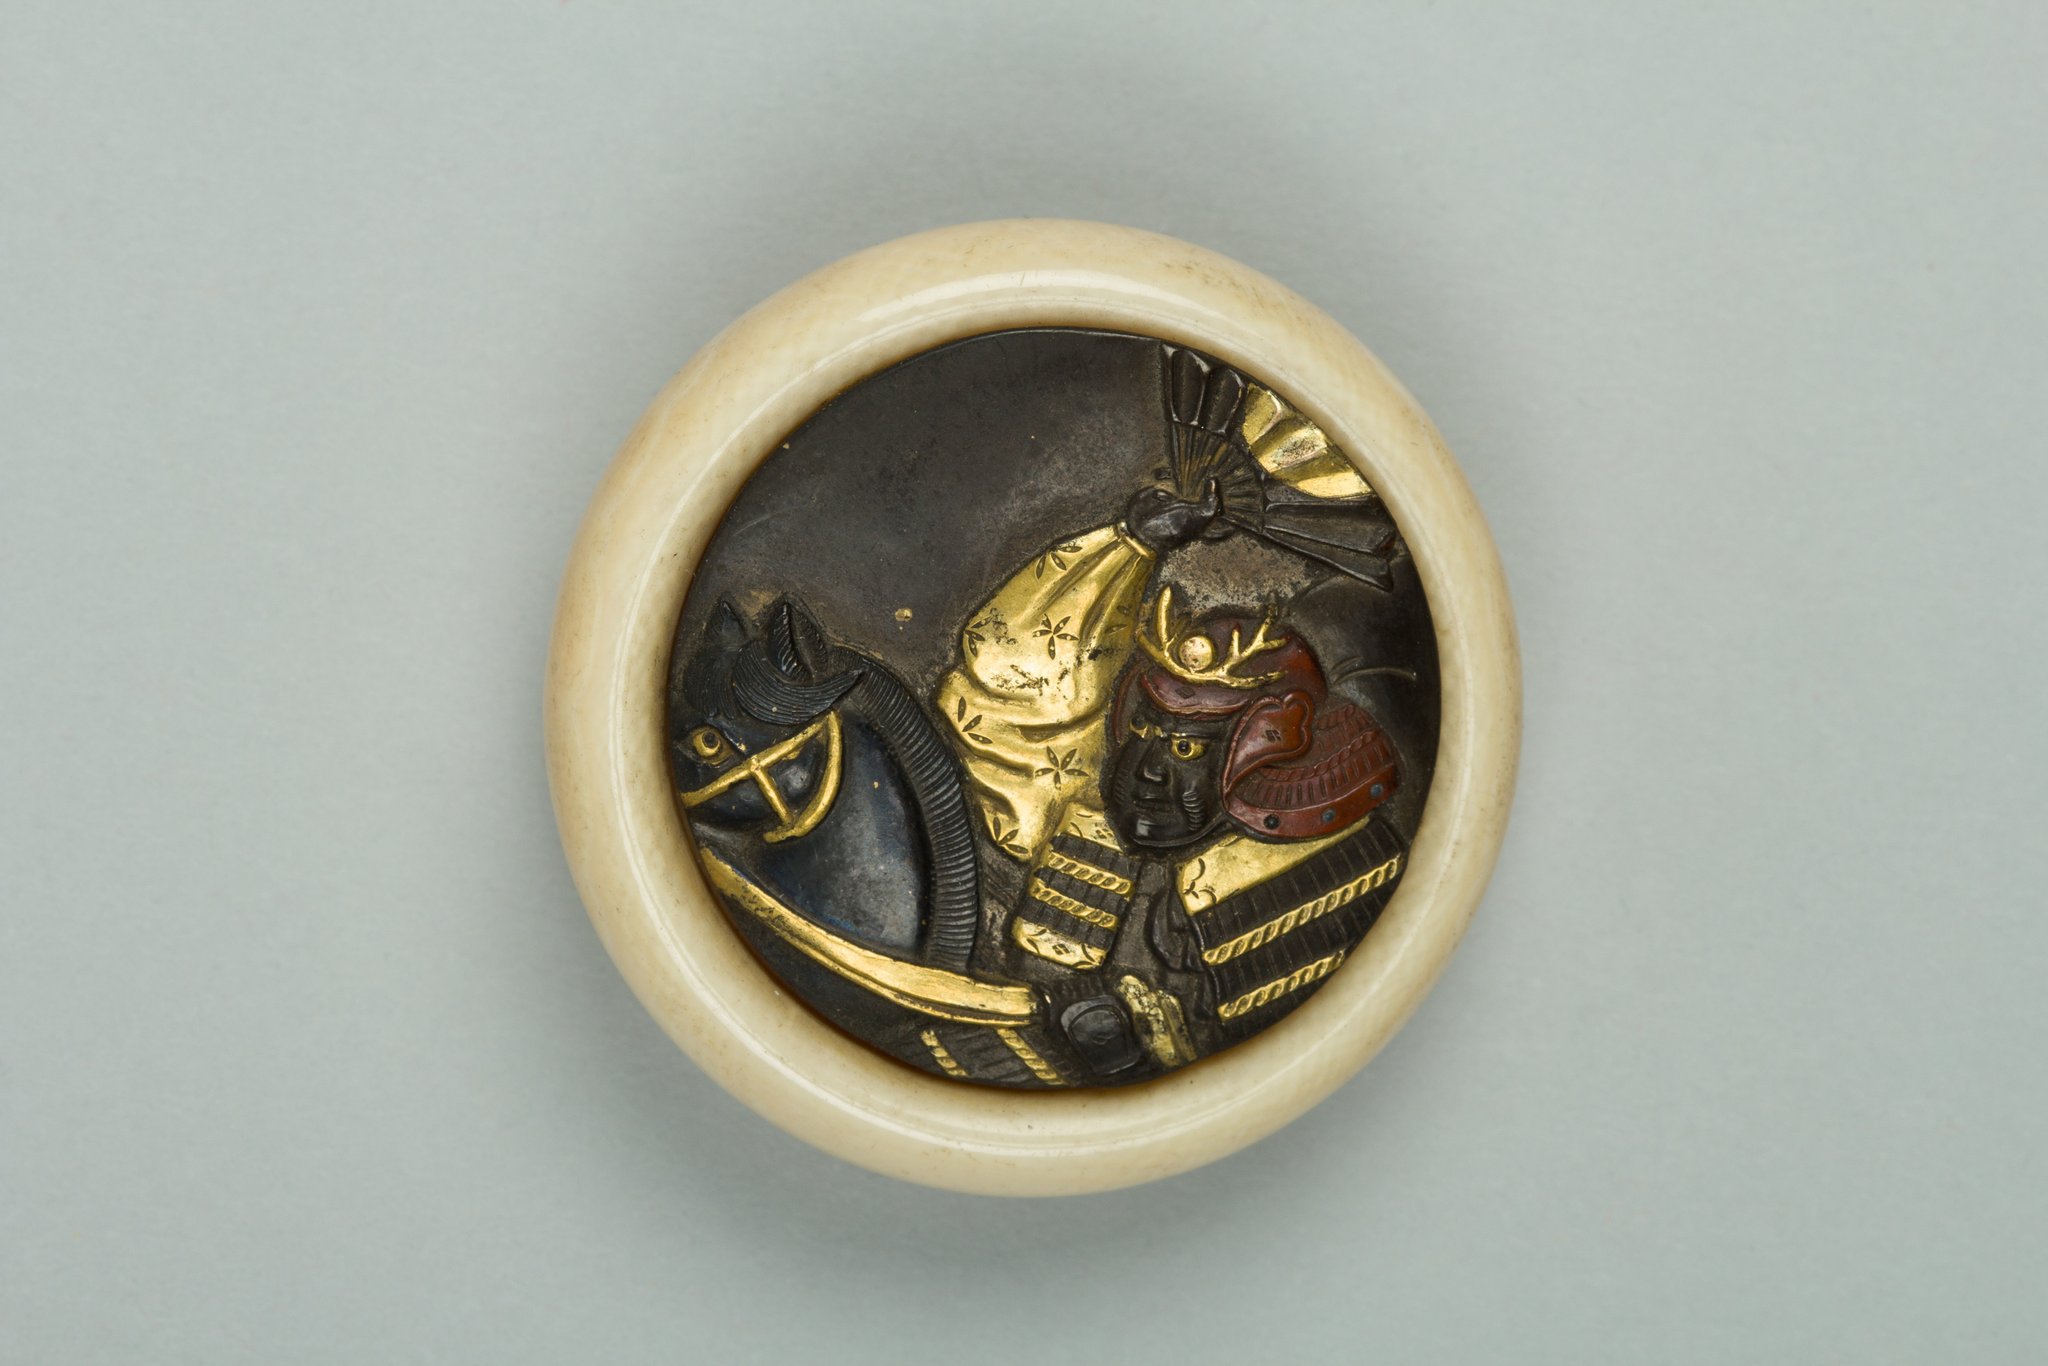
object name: netsuke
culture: japanese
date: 1801-1900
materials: bronze, gold, ivory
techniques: inlay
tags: fans,men,horses